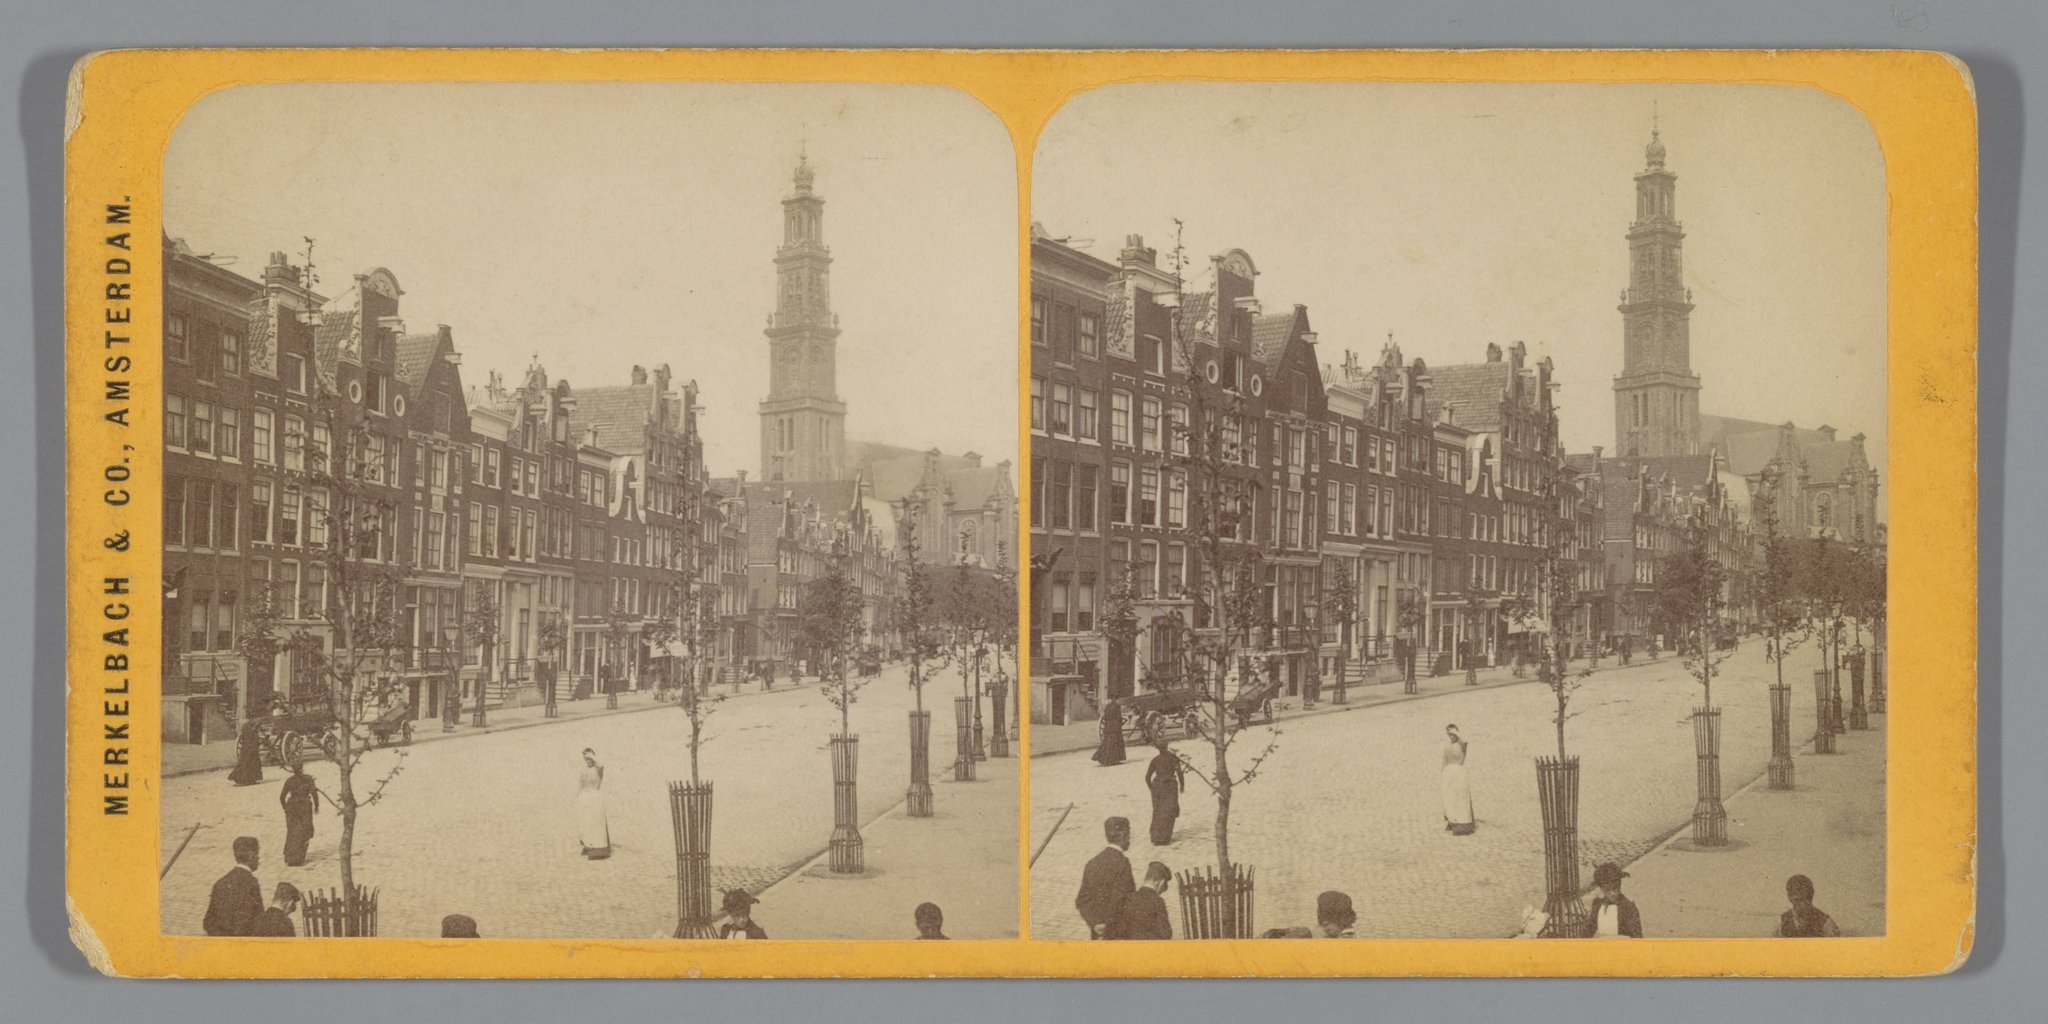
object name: stereograph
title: Gedempte Rozengracht, Amsterdam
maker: Anonymous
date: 1890-1910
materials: cardboard, paper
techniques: albumen print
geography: amsterdam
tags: street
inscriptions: inscription: ‘Ged. Rozengracht/ Amsterdam’